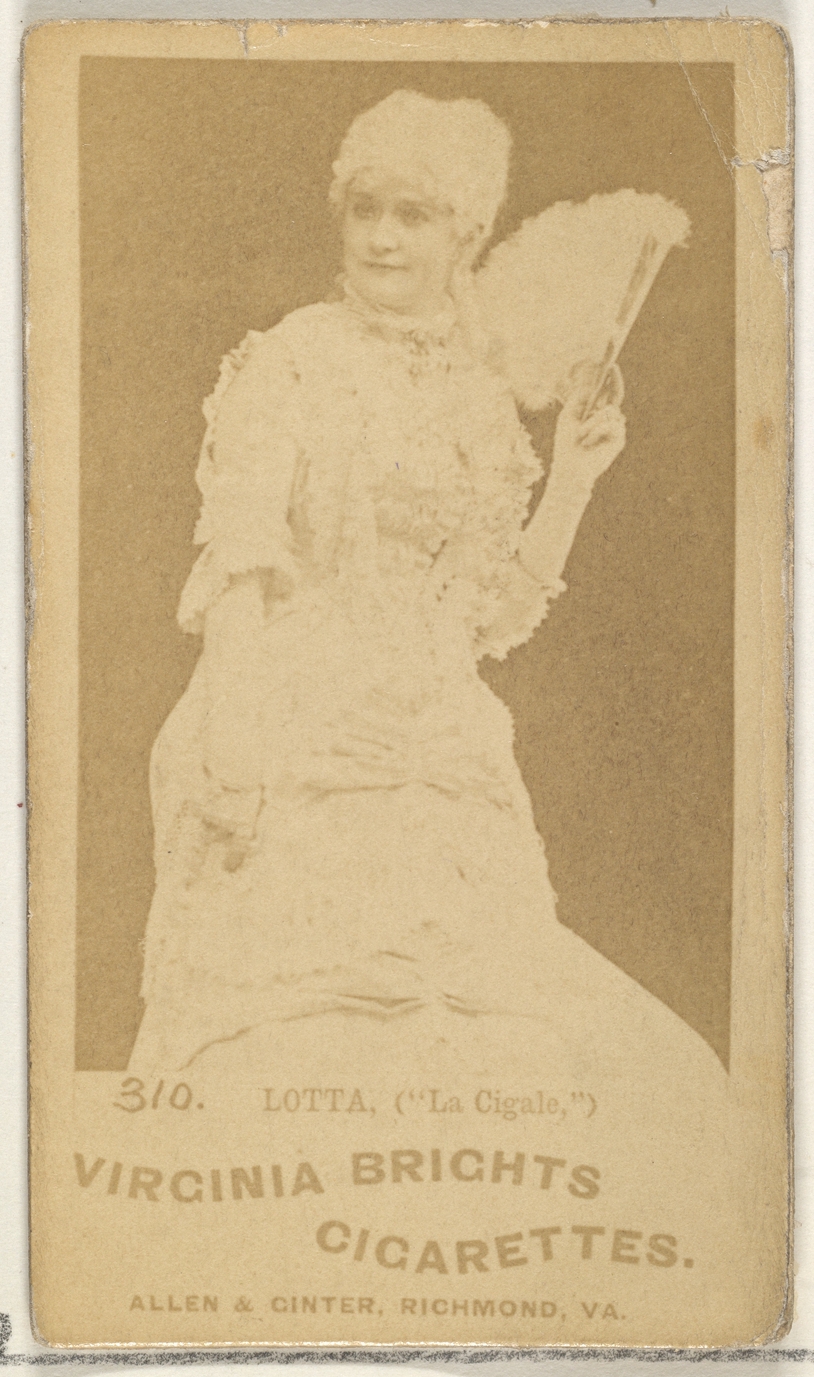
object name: photograph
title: Card 310, Lotta, "La Cigale," from the Actors and Actresses series (N45, Type 1) for Virginia Brights Cigarettes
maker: allen & ginter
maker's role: publisher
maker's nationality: american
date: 1888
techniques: albumen silver print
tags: portraits,women,actresses